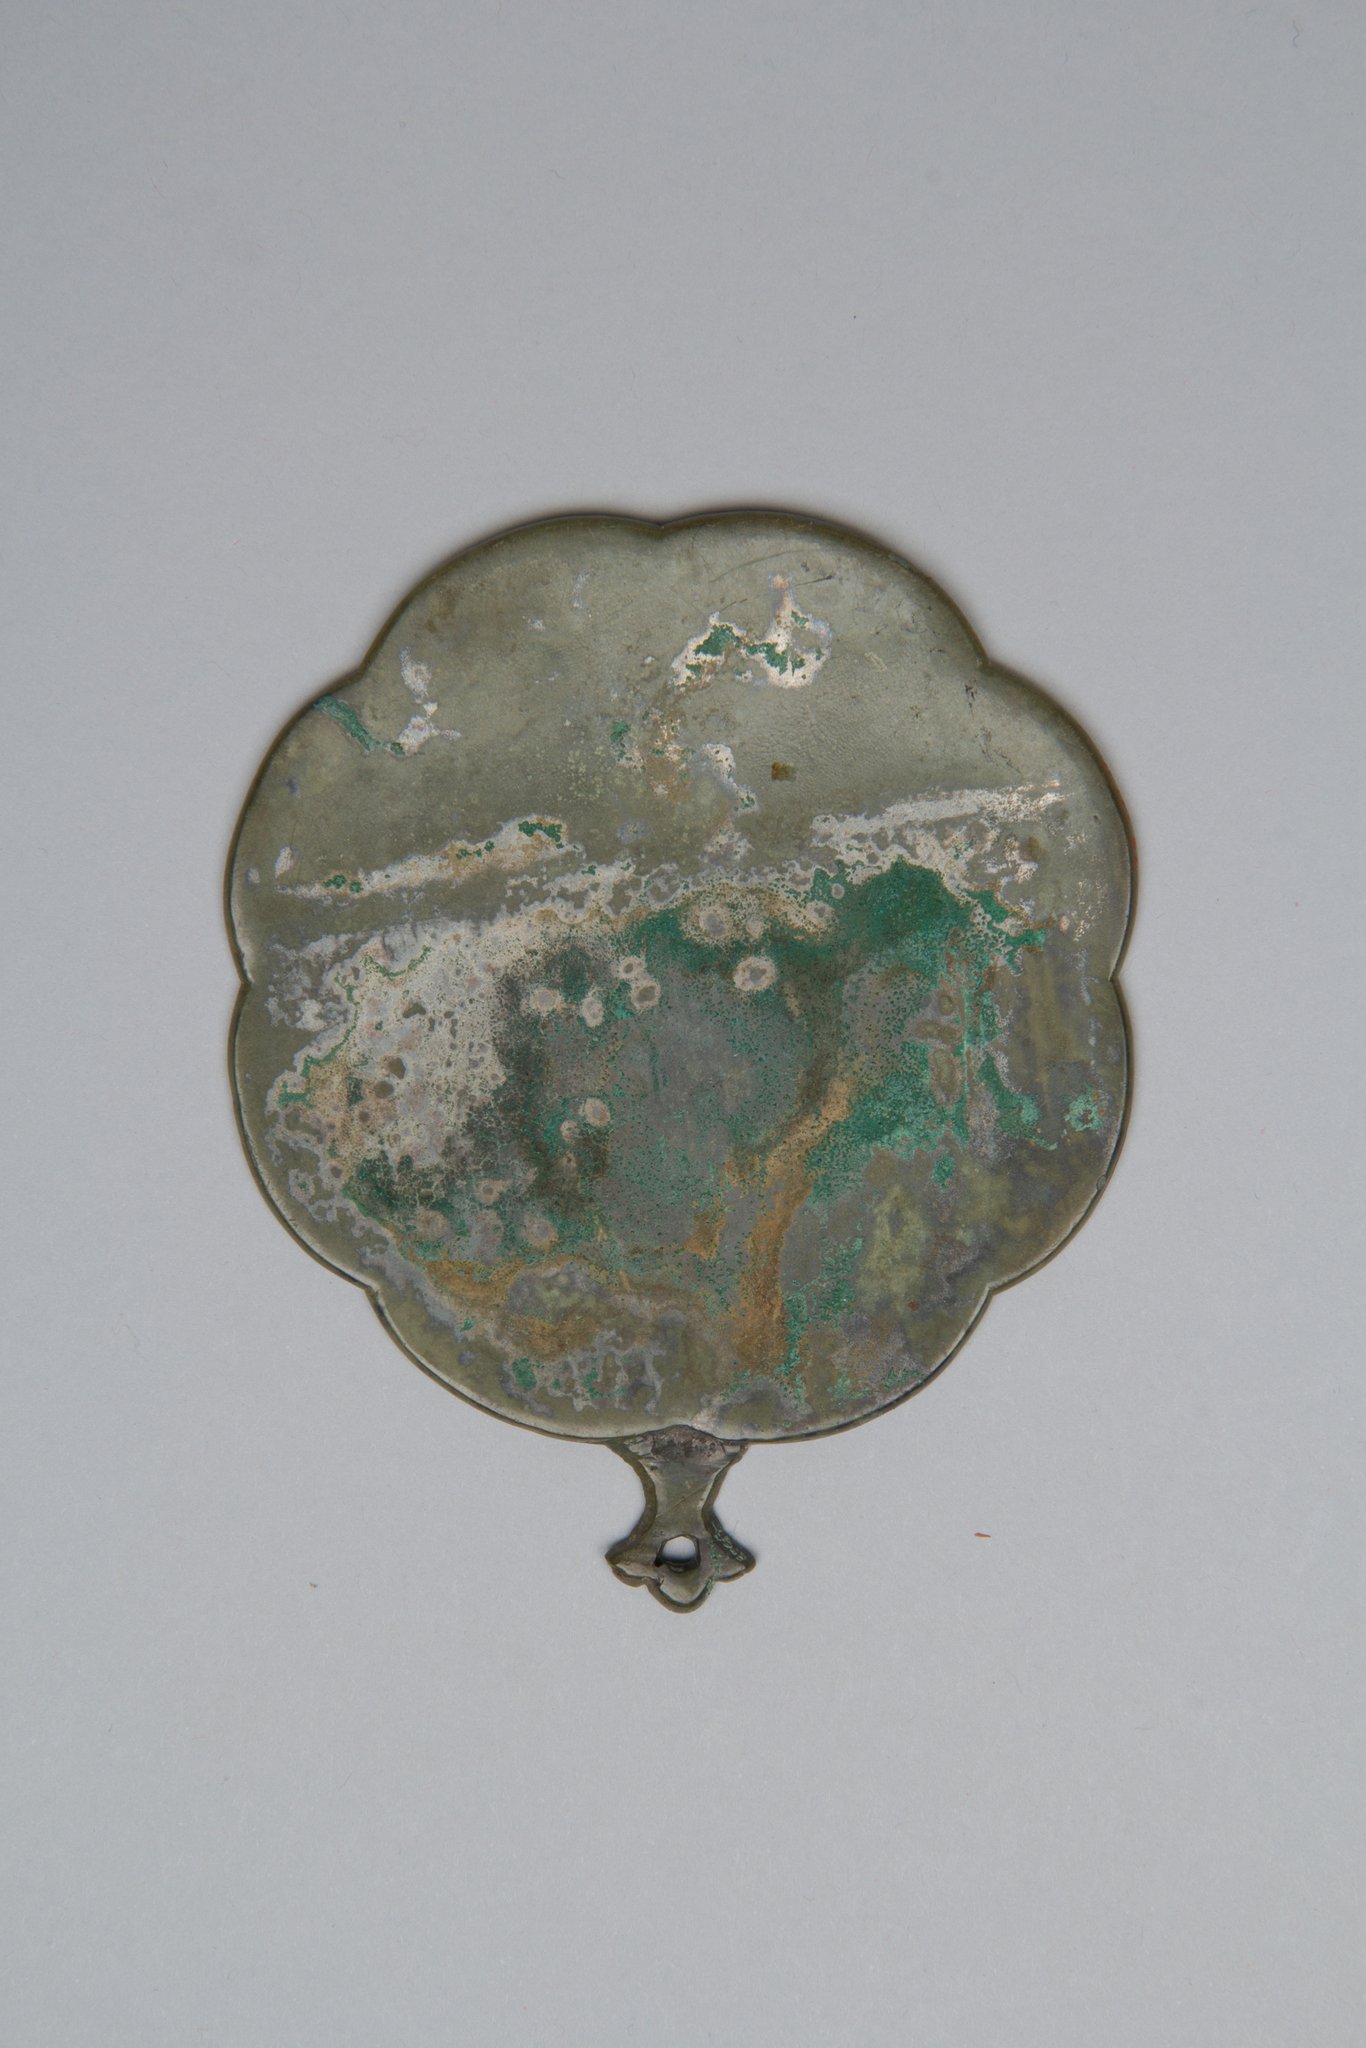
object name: mirror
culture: korean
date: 918-1392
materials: bronze